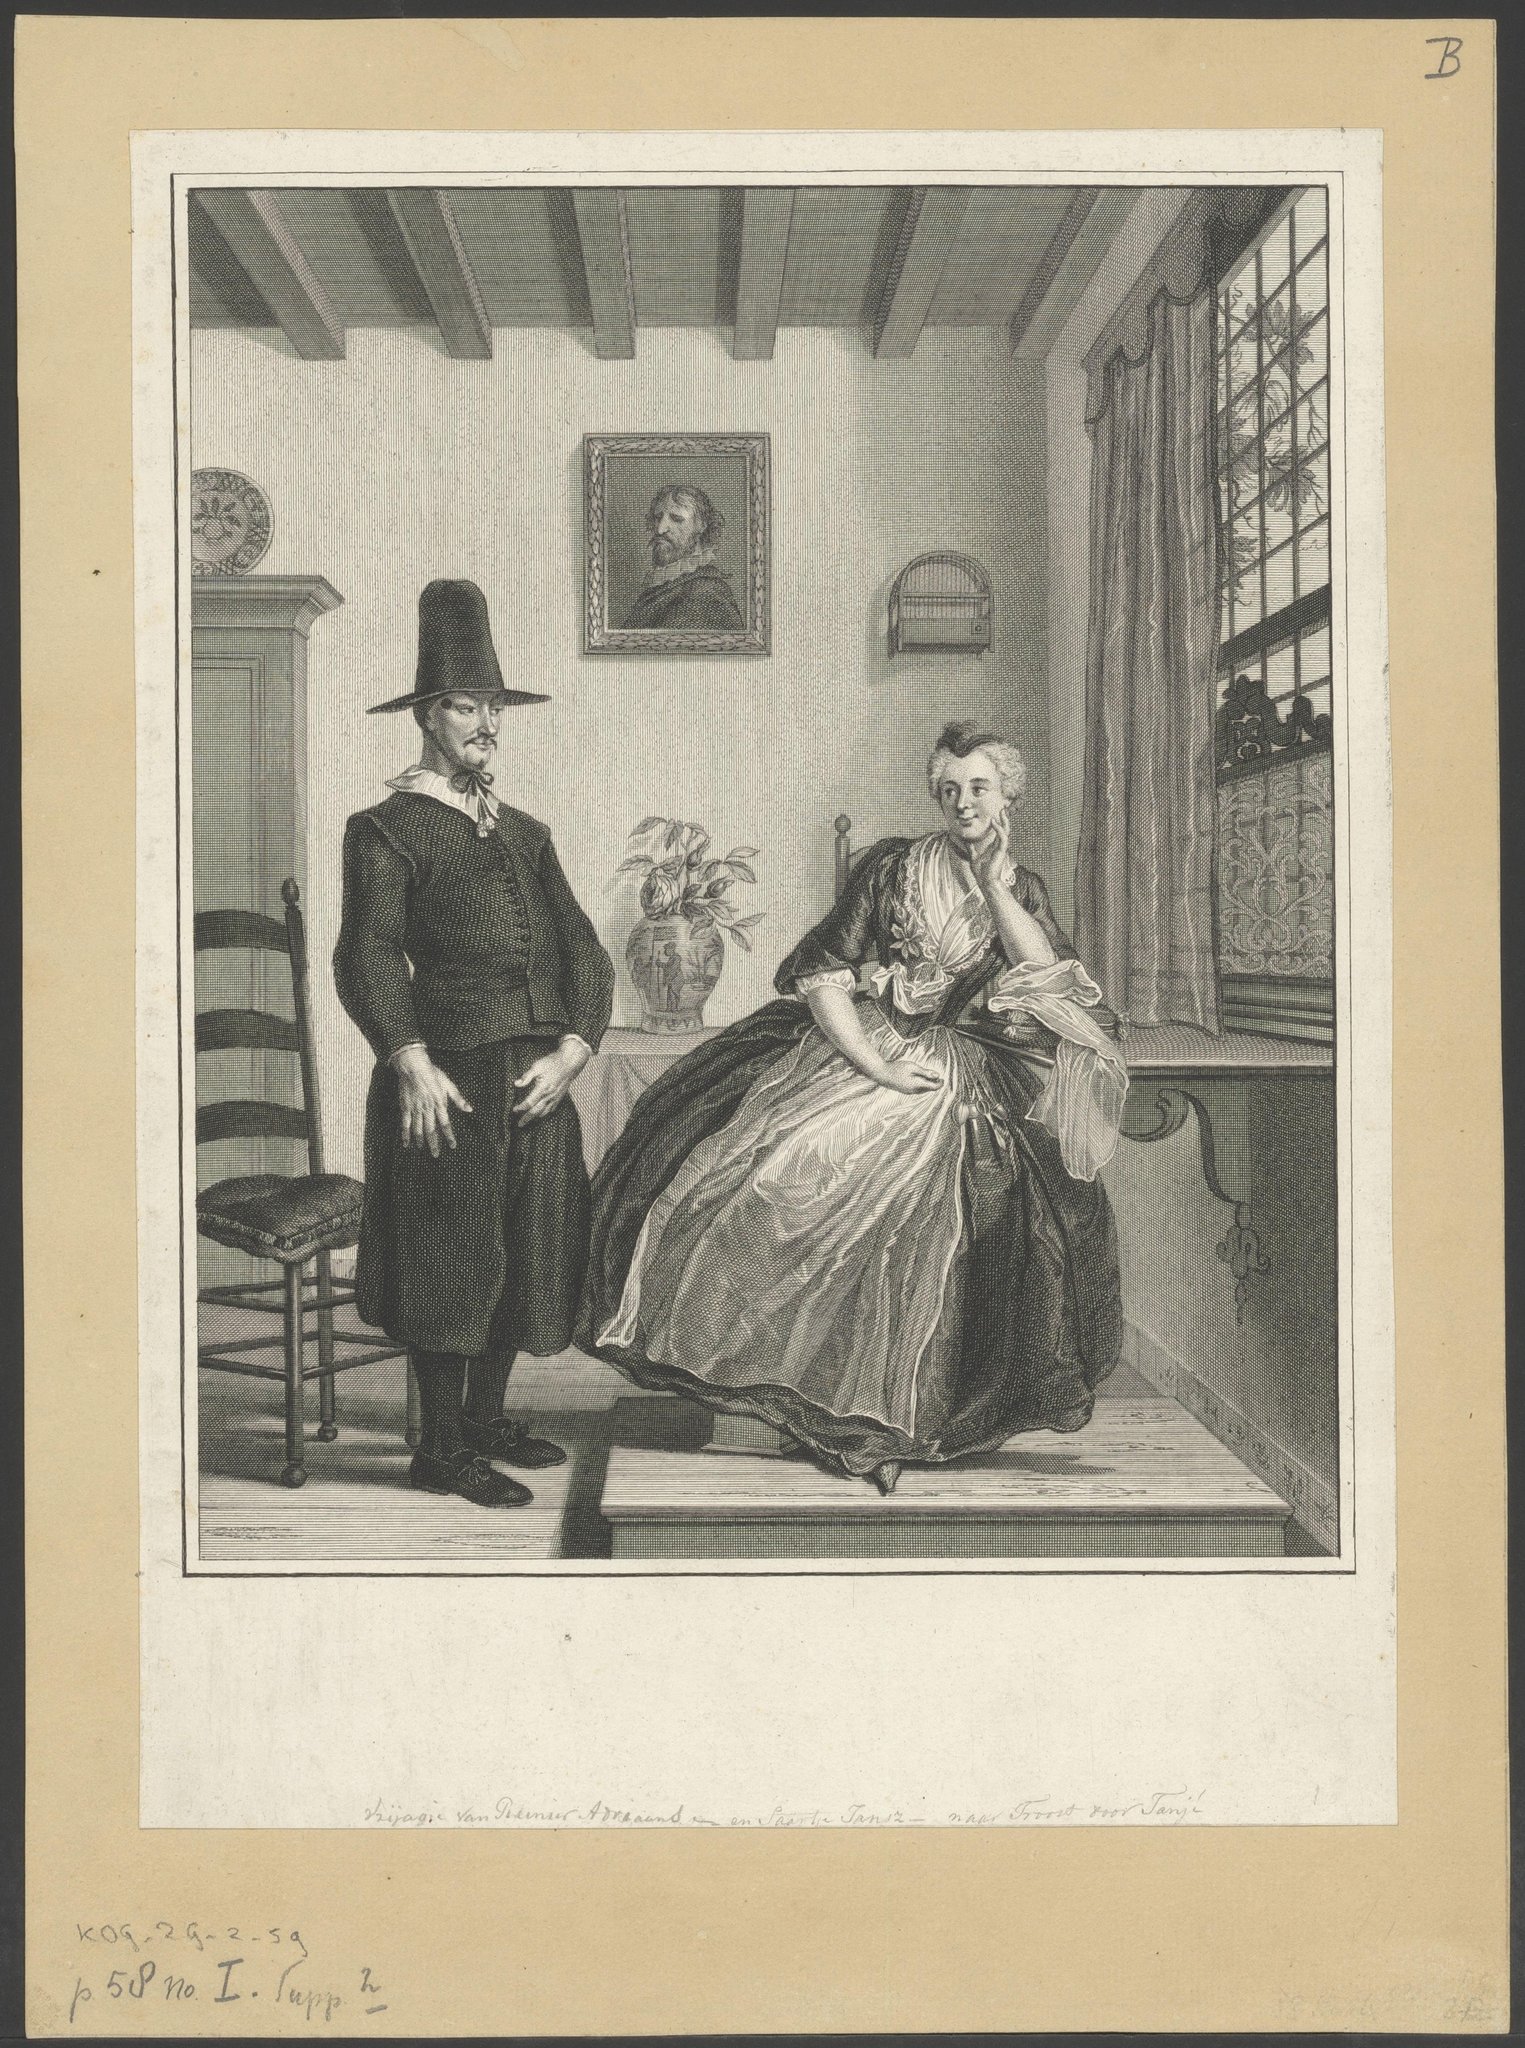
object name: print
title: Jan Claasz of de gewaande dienstmaagd: de liefdesverklaring van Reinier Adriaansz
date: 1754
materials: paper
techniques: engraving, etching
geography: amsterdam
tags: being refused, the proposal rejected, living-room, parlour, sitting-room, comedy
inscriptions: collector's mark: Lugt 2488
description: Reinier Adriaansz verklaart Saartje Jansz. in een huiskamer zijn liefde. Saartje Jansz wijst hem echter af. Vóór de verzen in de marge. Scène uit de komedie 'Jan Claasz of de gewaande dienstmaagd' van Thomas Asselijn.